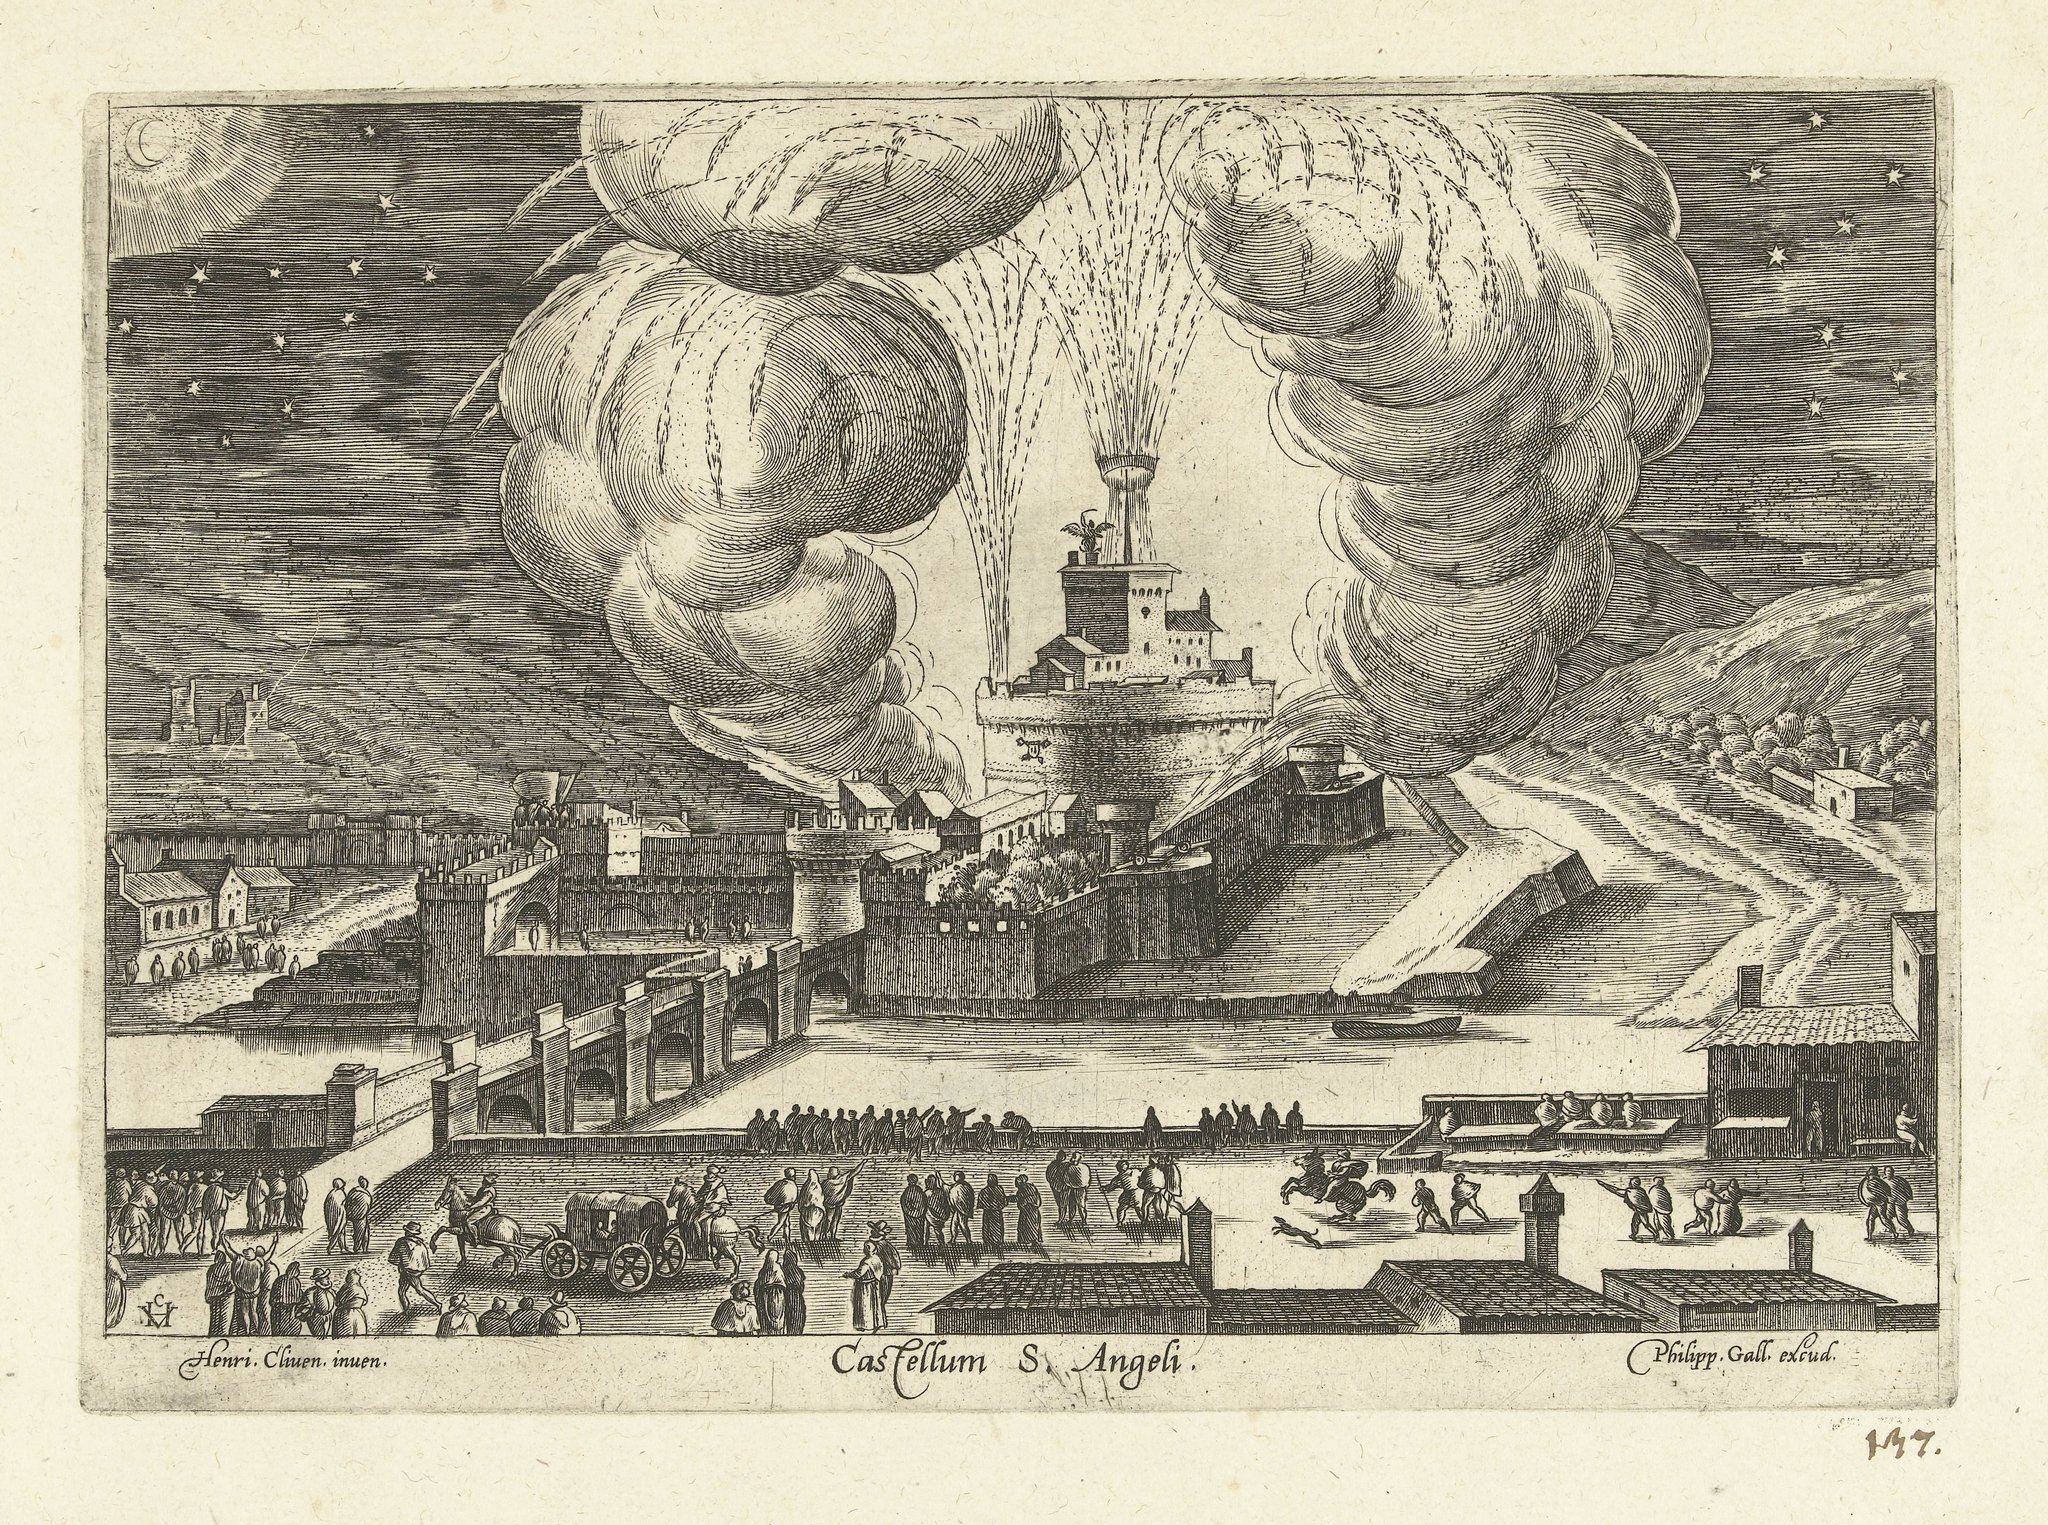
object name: print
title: Ruinarum varii prospectus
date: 1585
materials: paper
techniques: engraving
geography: antwerp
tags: bonfire, fire-works, city-view, and landscape with man-made constructions (+ city(-scape) with figures, staffage)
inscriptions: collector's mark: Lugt 2228, number: ‘137’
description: Gezicht op de Engelenburcht. Het is nacht en er wordt vuurwerk afgestoken. Op de voorgrond de straat met toeschouwers. De prent is deel van een serie die verschillende plaatsen in het Middellandse Zeegebied afbeeldt.